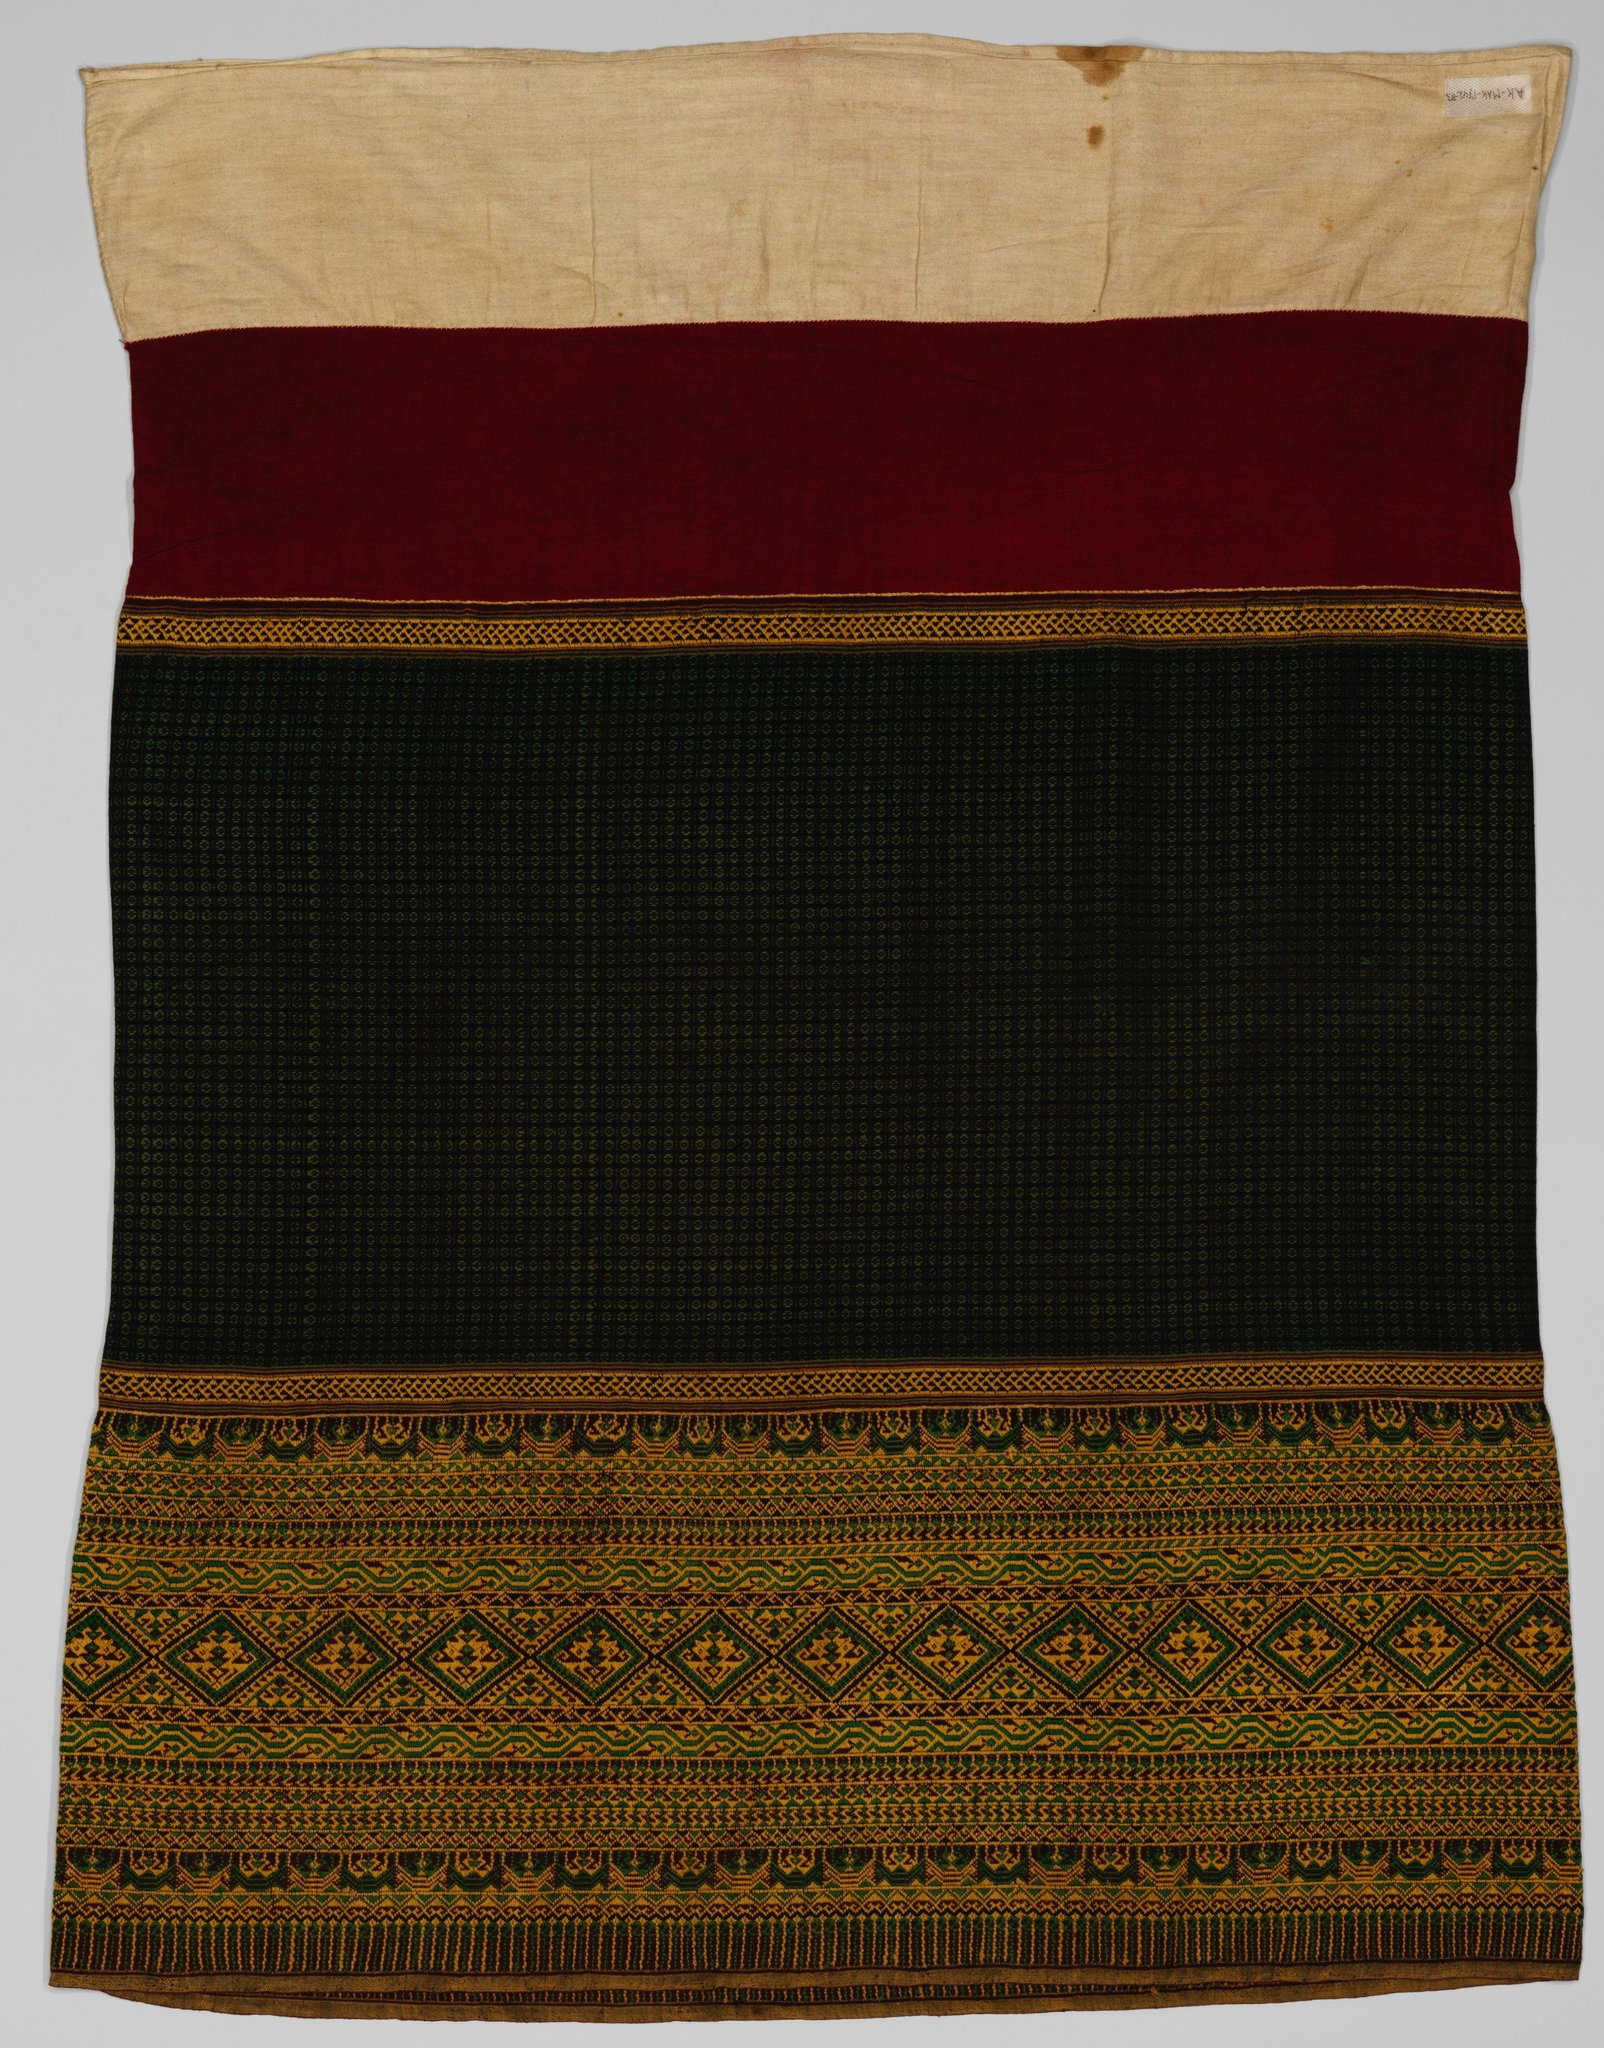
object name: cloth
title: Pa sin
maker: Anonymous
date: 1900-1949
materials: cotton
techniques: weave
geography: thailand